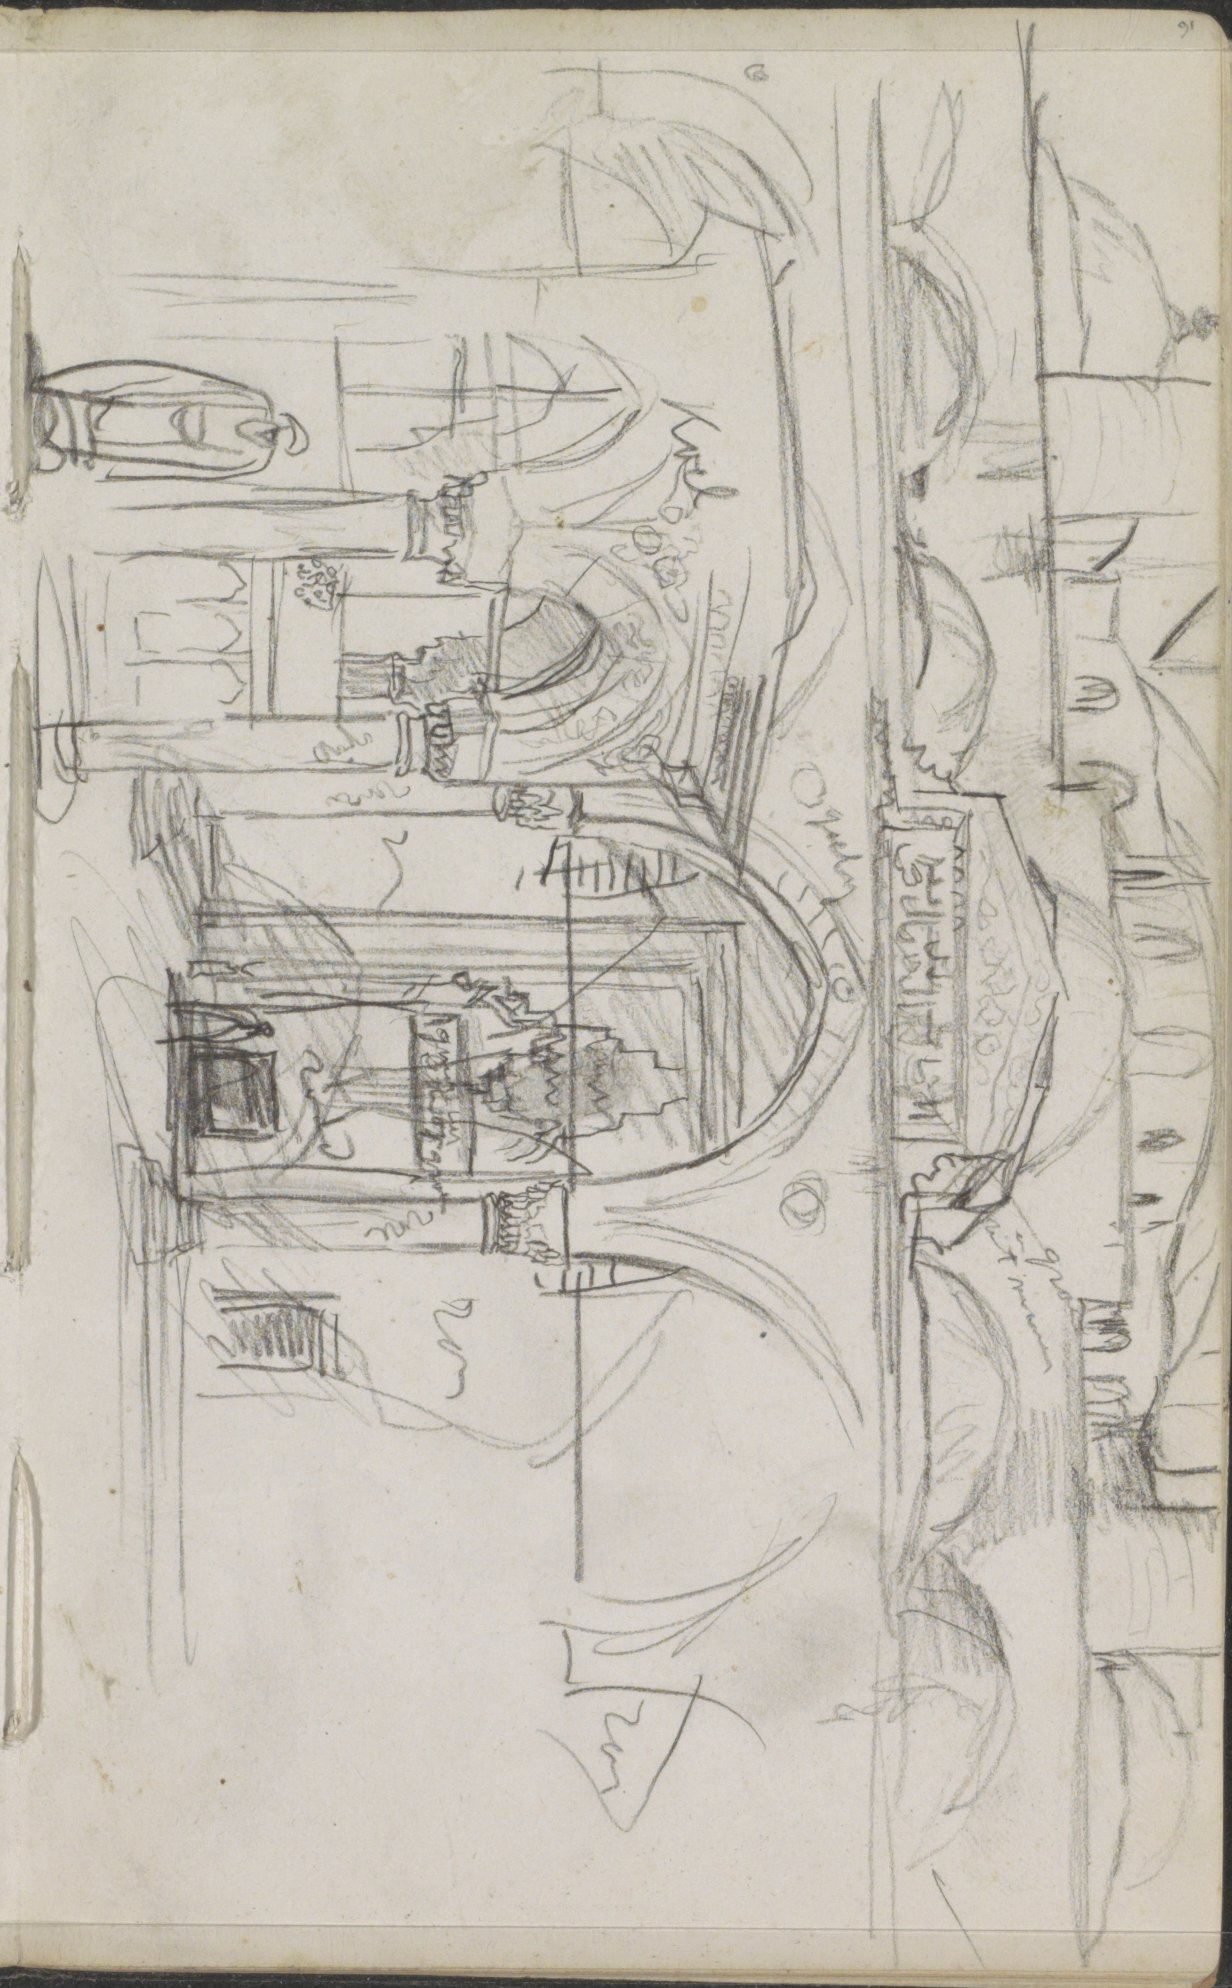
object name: sketchbook leaf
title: Fontein bij het voorportaal van een moskee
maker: marius bauer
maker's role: draughtsman, print maker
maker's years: 1867-1932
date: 1896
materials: chalk, paper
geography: istanbul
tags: ornamental fountain, temple, shrine ~ islam, mohammedanism, arcade ~ architecture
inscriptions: kleurnotitie, handgeschreven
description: Mogelijk het voorportaal van de Sultan Ahmetmoskee of Blauwe moskee. Pagina 91 uit een schetsboek met 53 bladen.